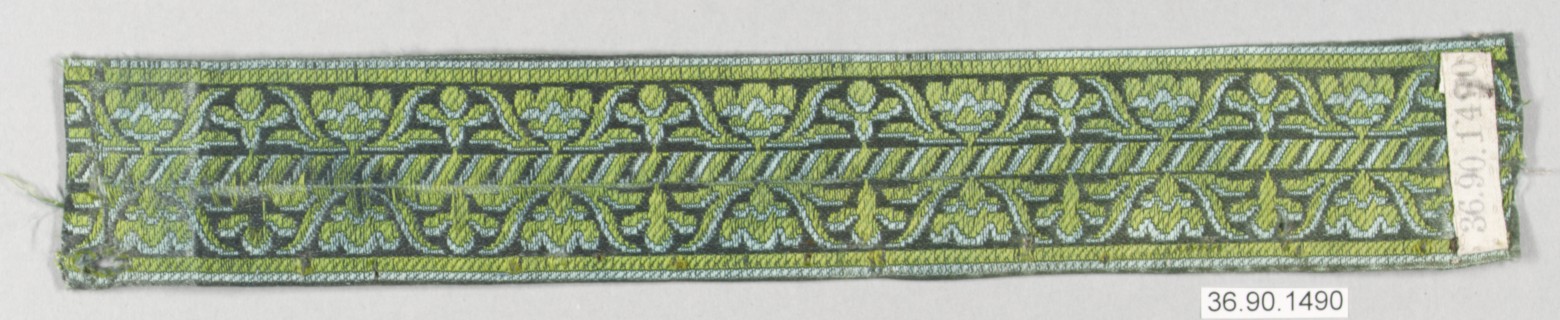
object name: ribbon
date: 1801-1900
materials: silk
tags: flowers